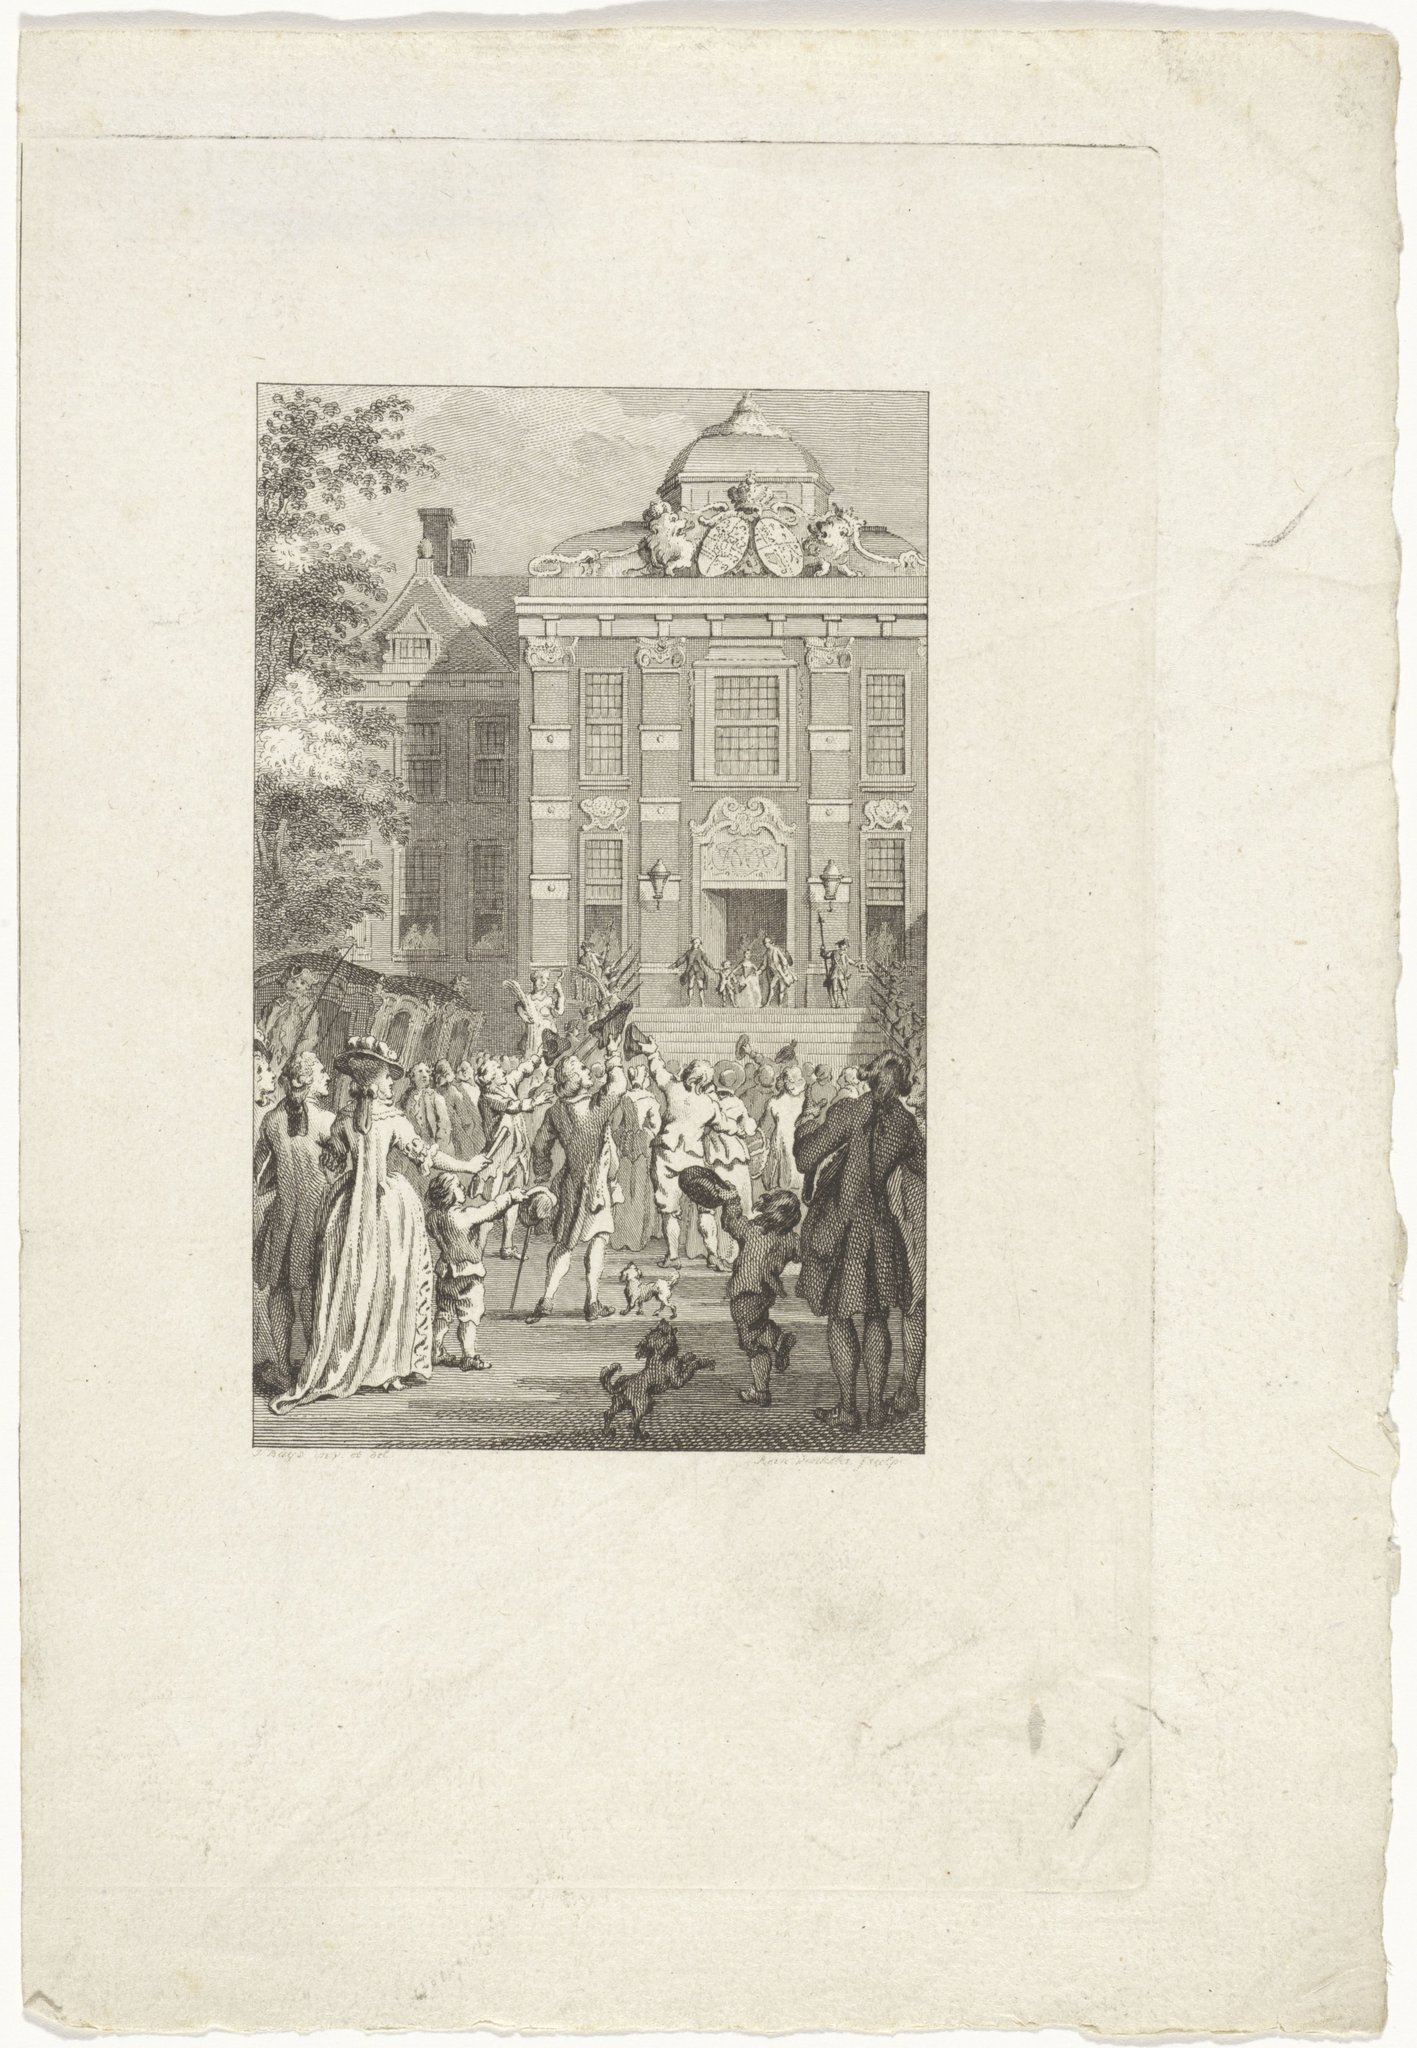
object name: print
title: Willem V vertoont zich als Ridder in de Orde van de Kousenband op het bordes van Huis ten Bosch, 1752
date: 1788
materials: paper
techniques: engraving, etching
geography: amsterdam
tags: the hague, william v (prince of orange), knighthood order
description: De jonge prins Willem V vertoont zich na zijn installatie als Ridder in de Orde van de Kousenband op het bordes van Paleis Huis Ten Bosch, 5 juni 1752. Op de straat voor het paleis wordt hij toegejuichd door een verzamelde menigte.